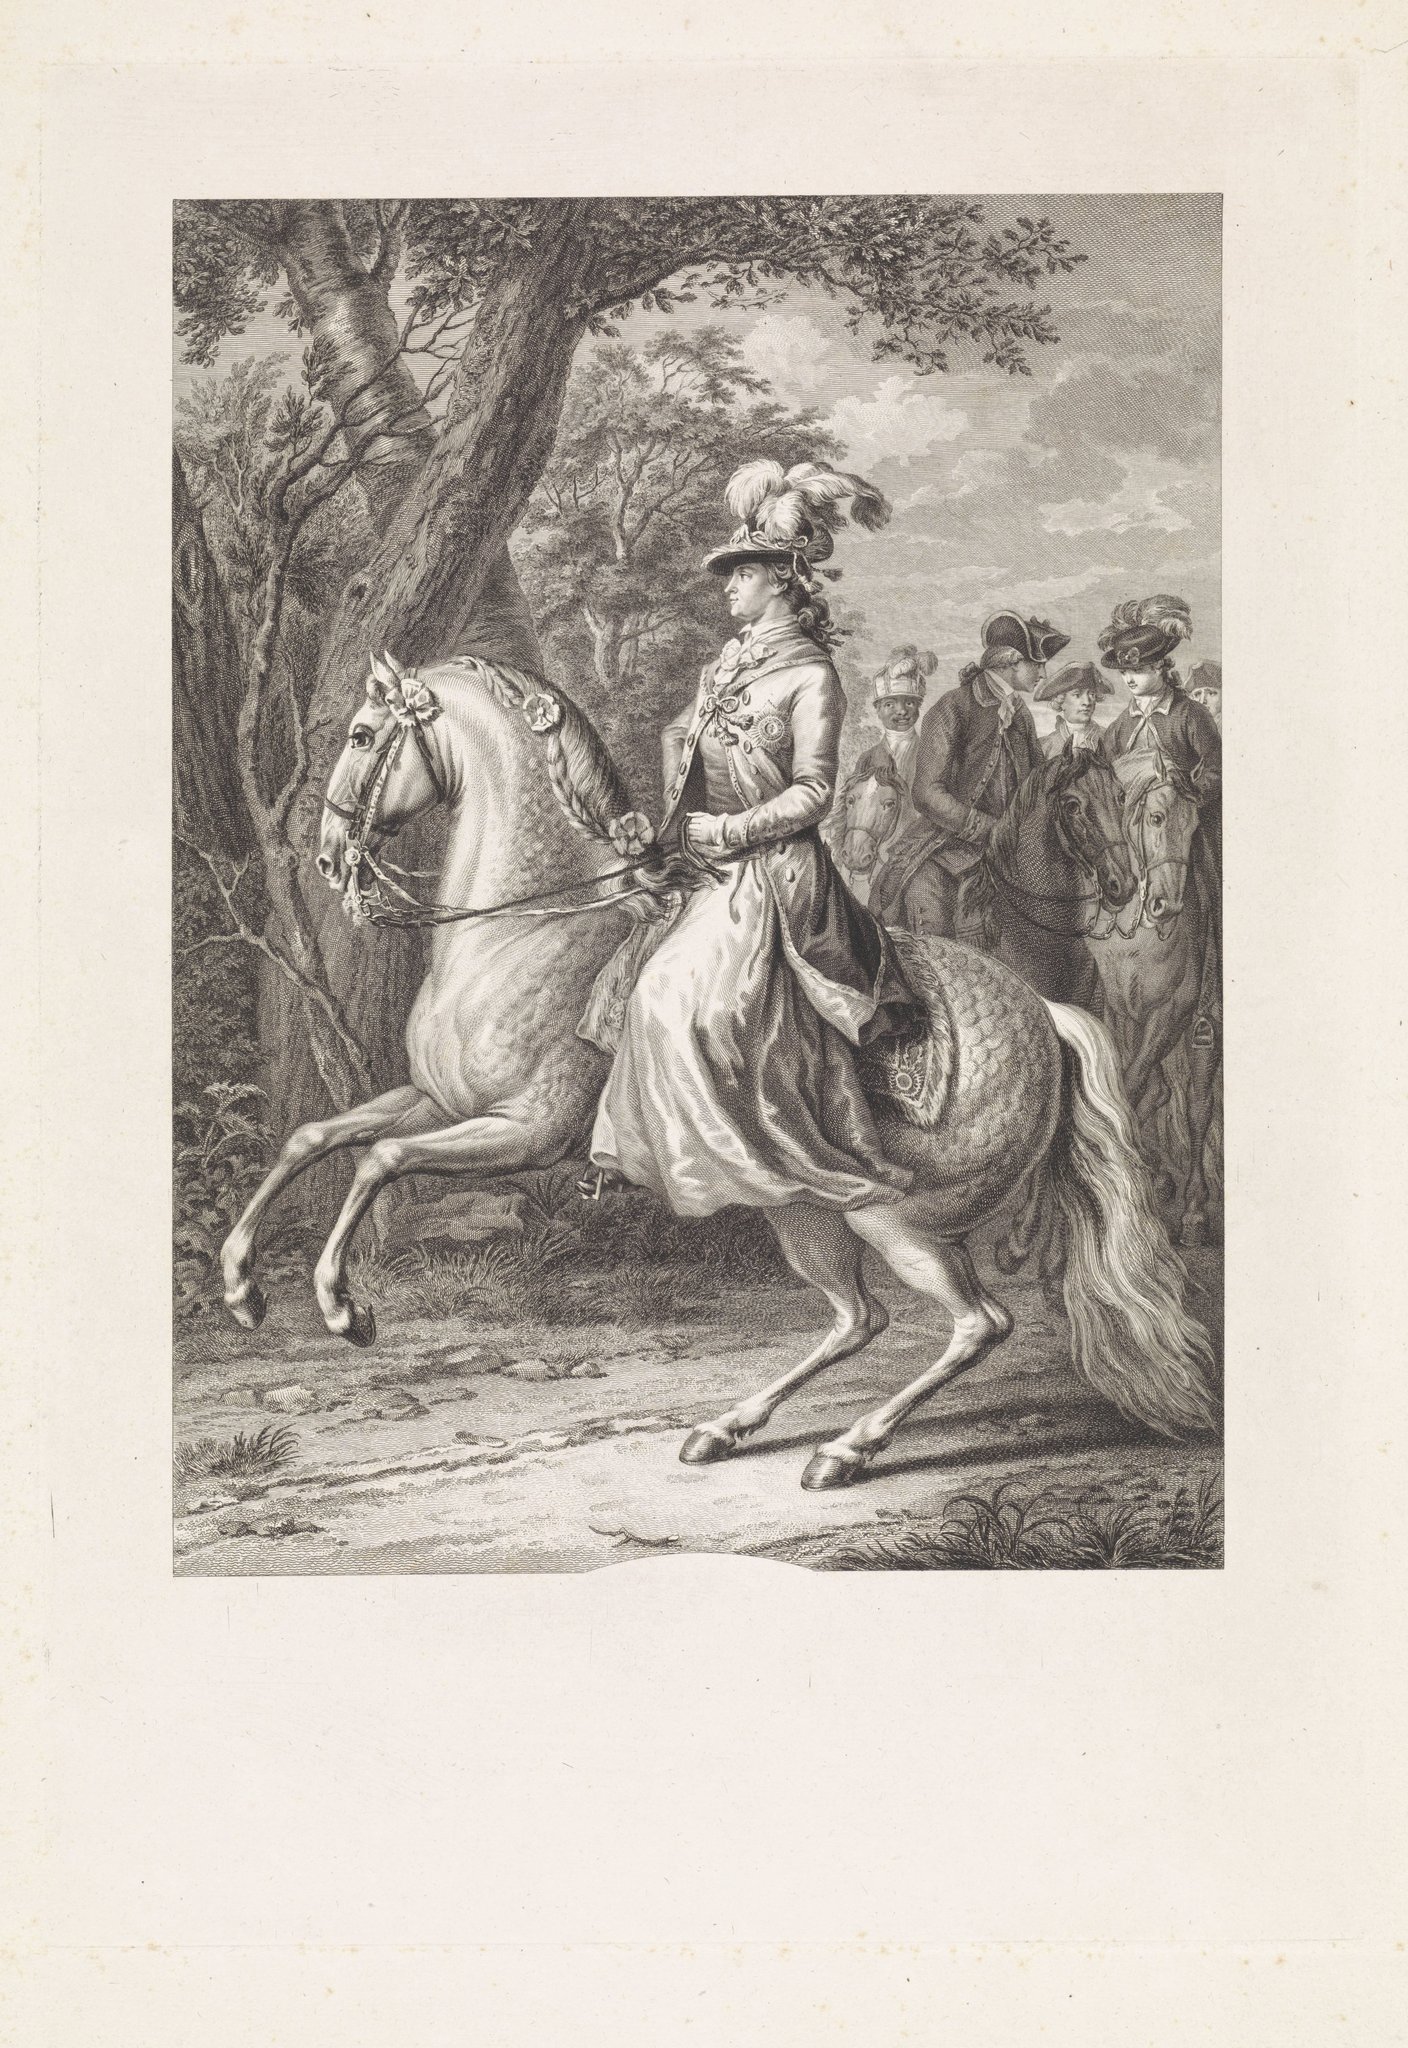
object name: print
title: Portret van Wilhelmina van Pruisen, te paard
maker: reinier vinkeles (i)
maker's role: draughtsman, print maker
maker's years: 1741-1816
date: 1779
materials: paper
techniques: engraving, etching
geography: amsterdam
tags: berlin, wilhelmina of prussia (princess of orange), horse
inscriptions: collector's mark: Lugt 2233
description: Portret van Wilhelmina van Pruisen, te paard in een landschap. Achter haar haar gevolg.